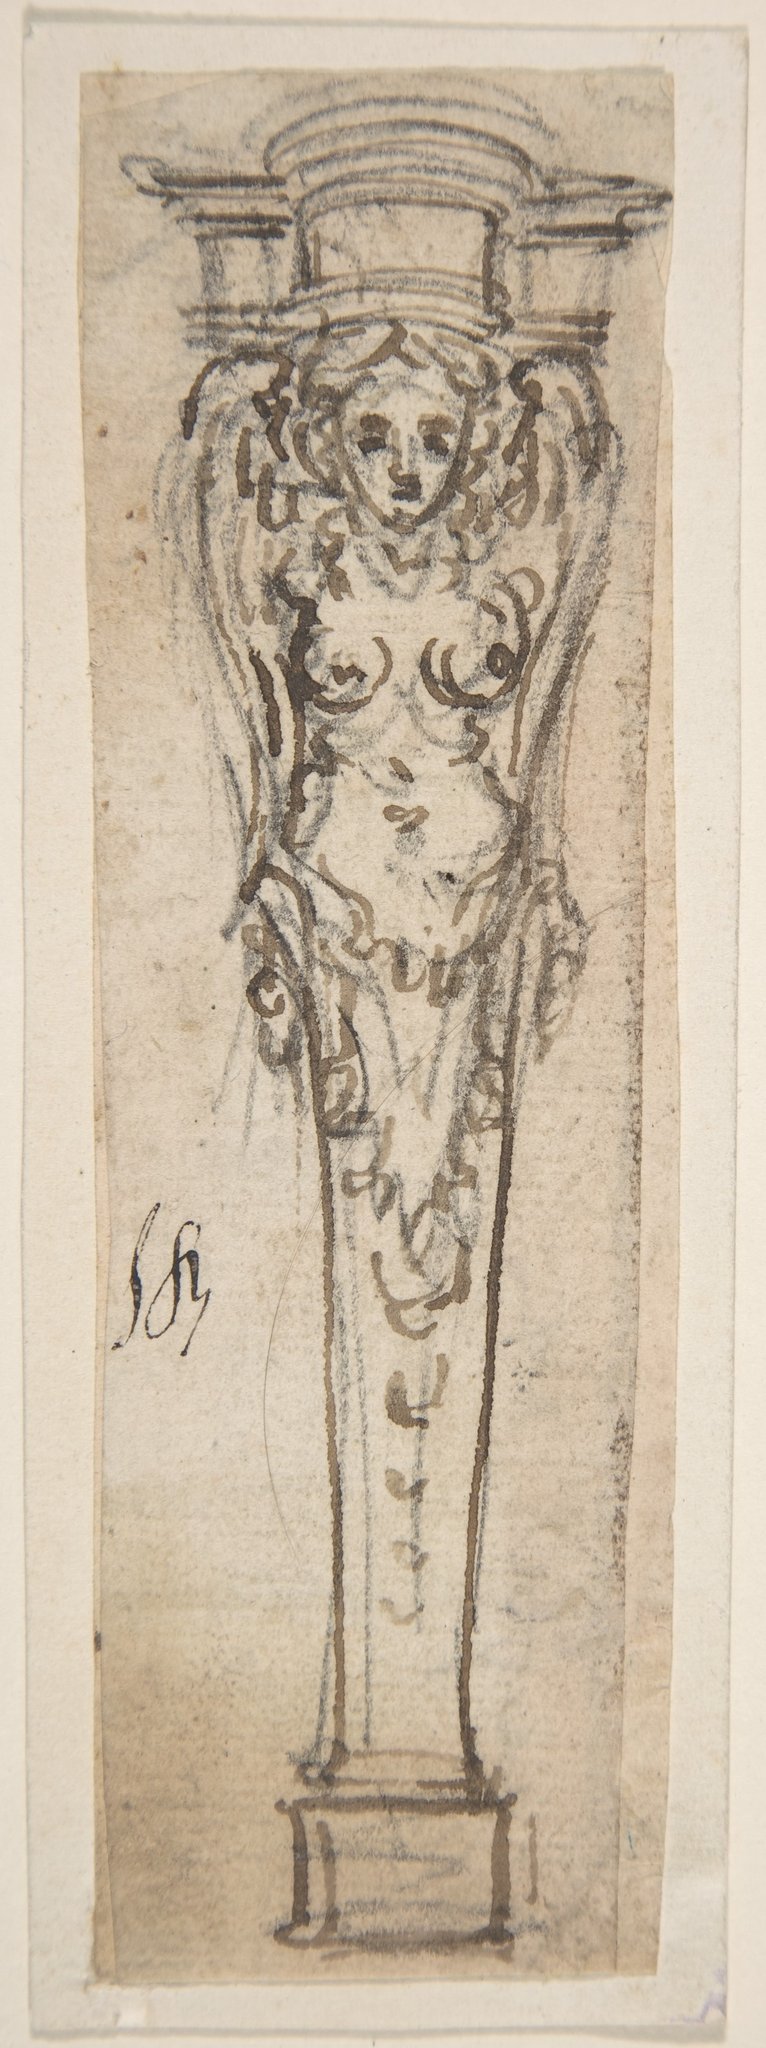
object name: drawing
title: Design for a Term Shaped like a Winged Female Figure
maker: giovanni battista foggini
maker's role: artist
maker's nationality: italian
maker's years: 1652-1725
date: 1672-1725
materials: chalk, ink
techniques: pen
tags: caryatids